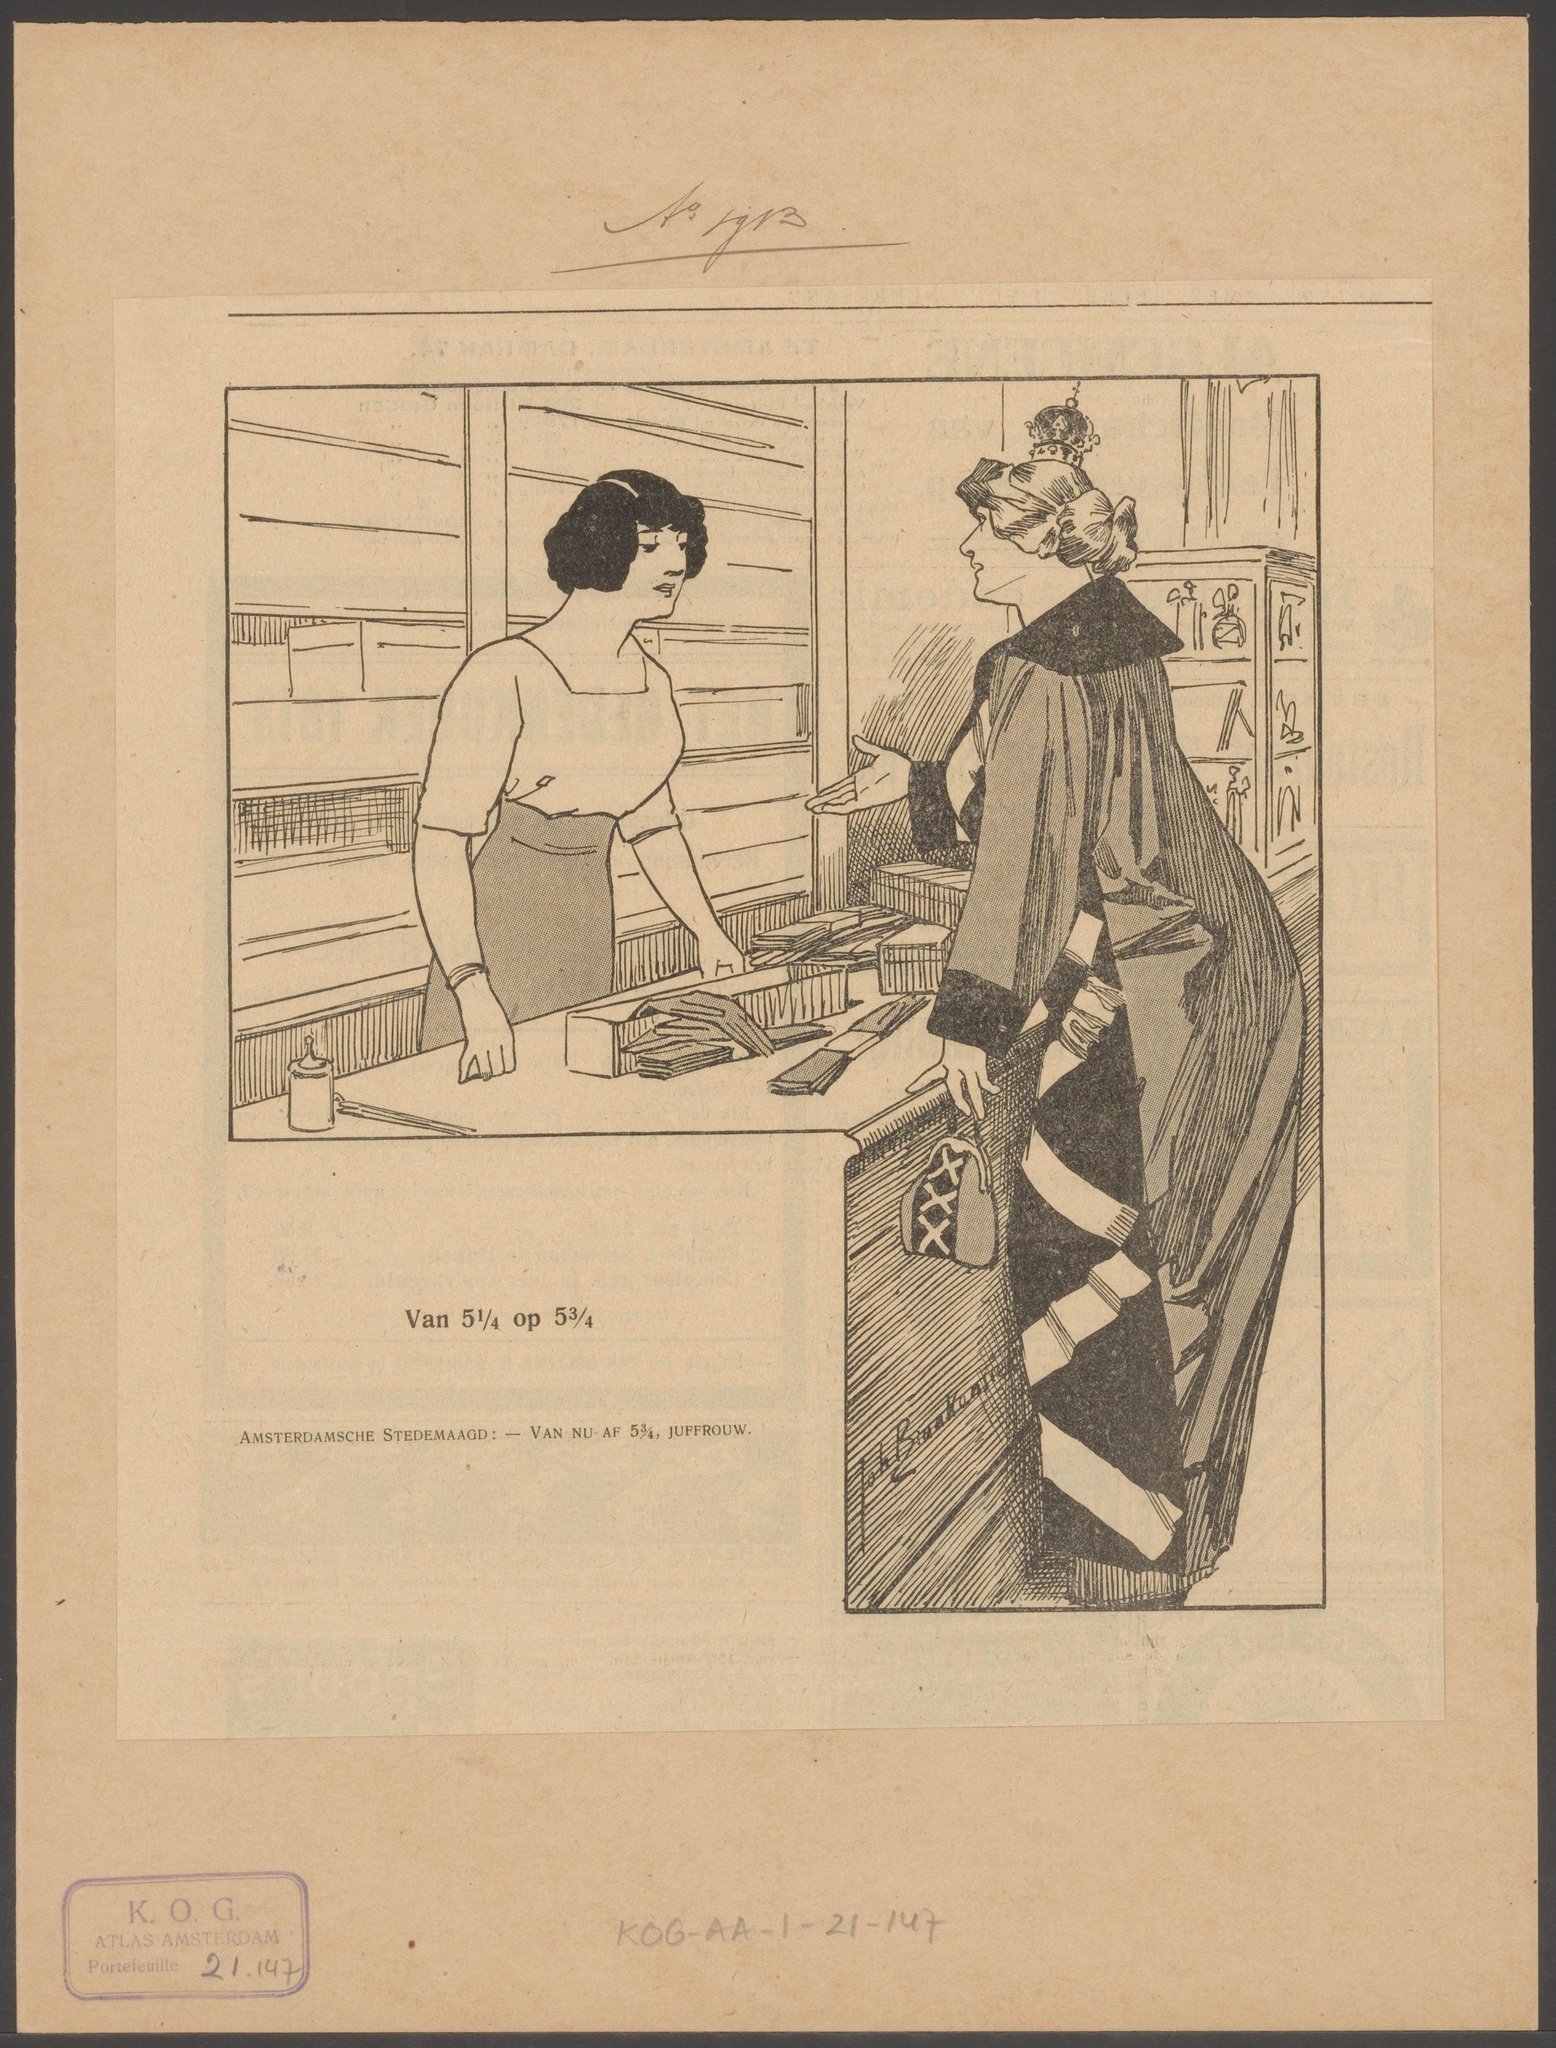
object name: photomechanical print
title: Stedenmaagd van Amsterdam spreekt tegen verkoopster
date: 1913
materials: paper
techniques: letterpress printing, line block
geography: netherlands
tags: city-crown, mural crown, shop, store, counter ~ shop, personification of a city, town-patron(ess), gloves, mittens, etc., political caricatures and satires, amsterdam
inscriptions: collector's mark: Lugt 1641b, inscription: ‘A◦. 1913’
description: De handschoenmaat is groter geworden. Onderwerpsrubriek binnen de Atlas Amsterdam: Belastingen.